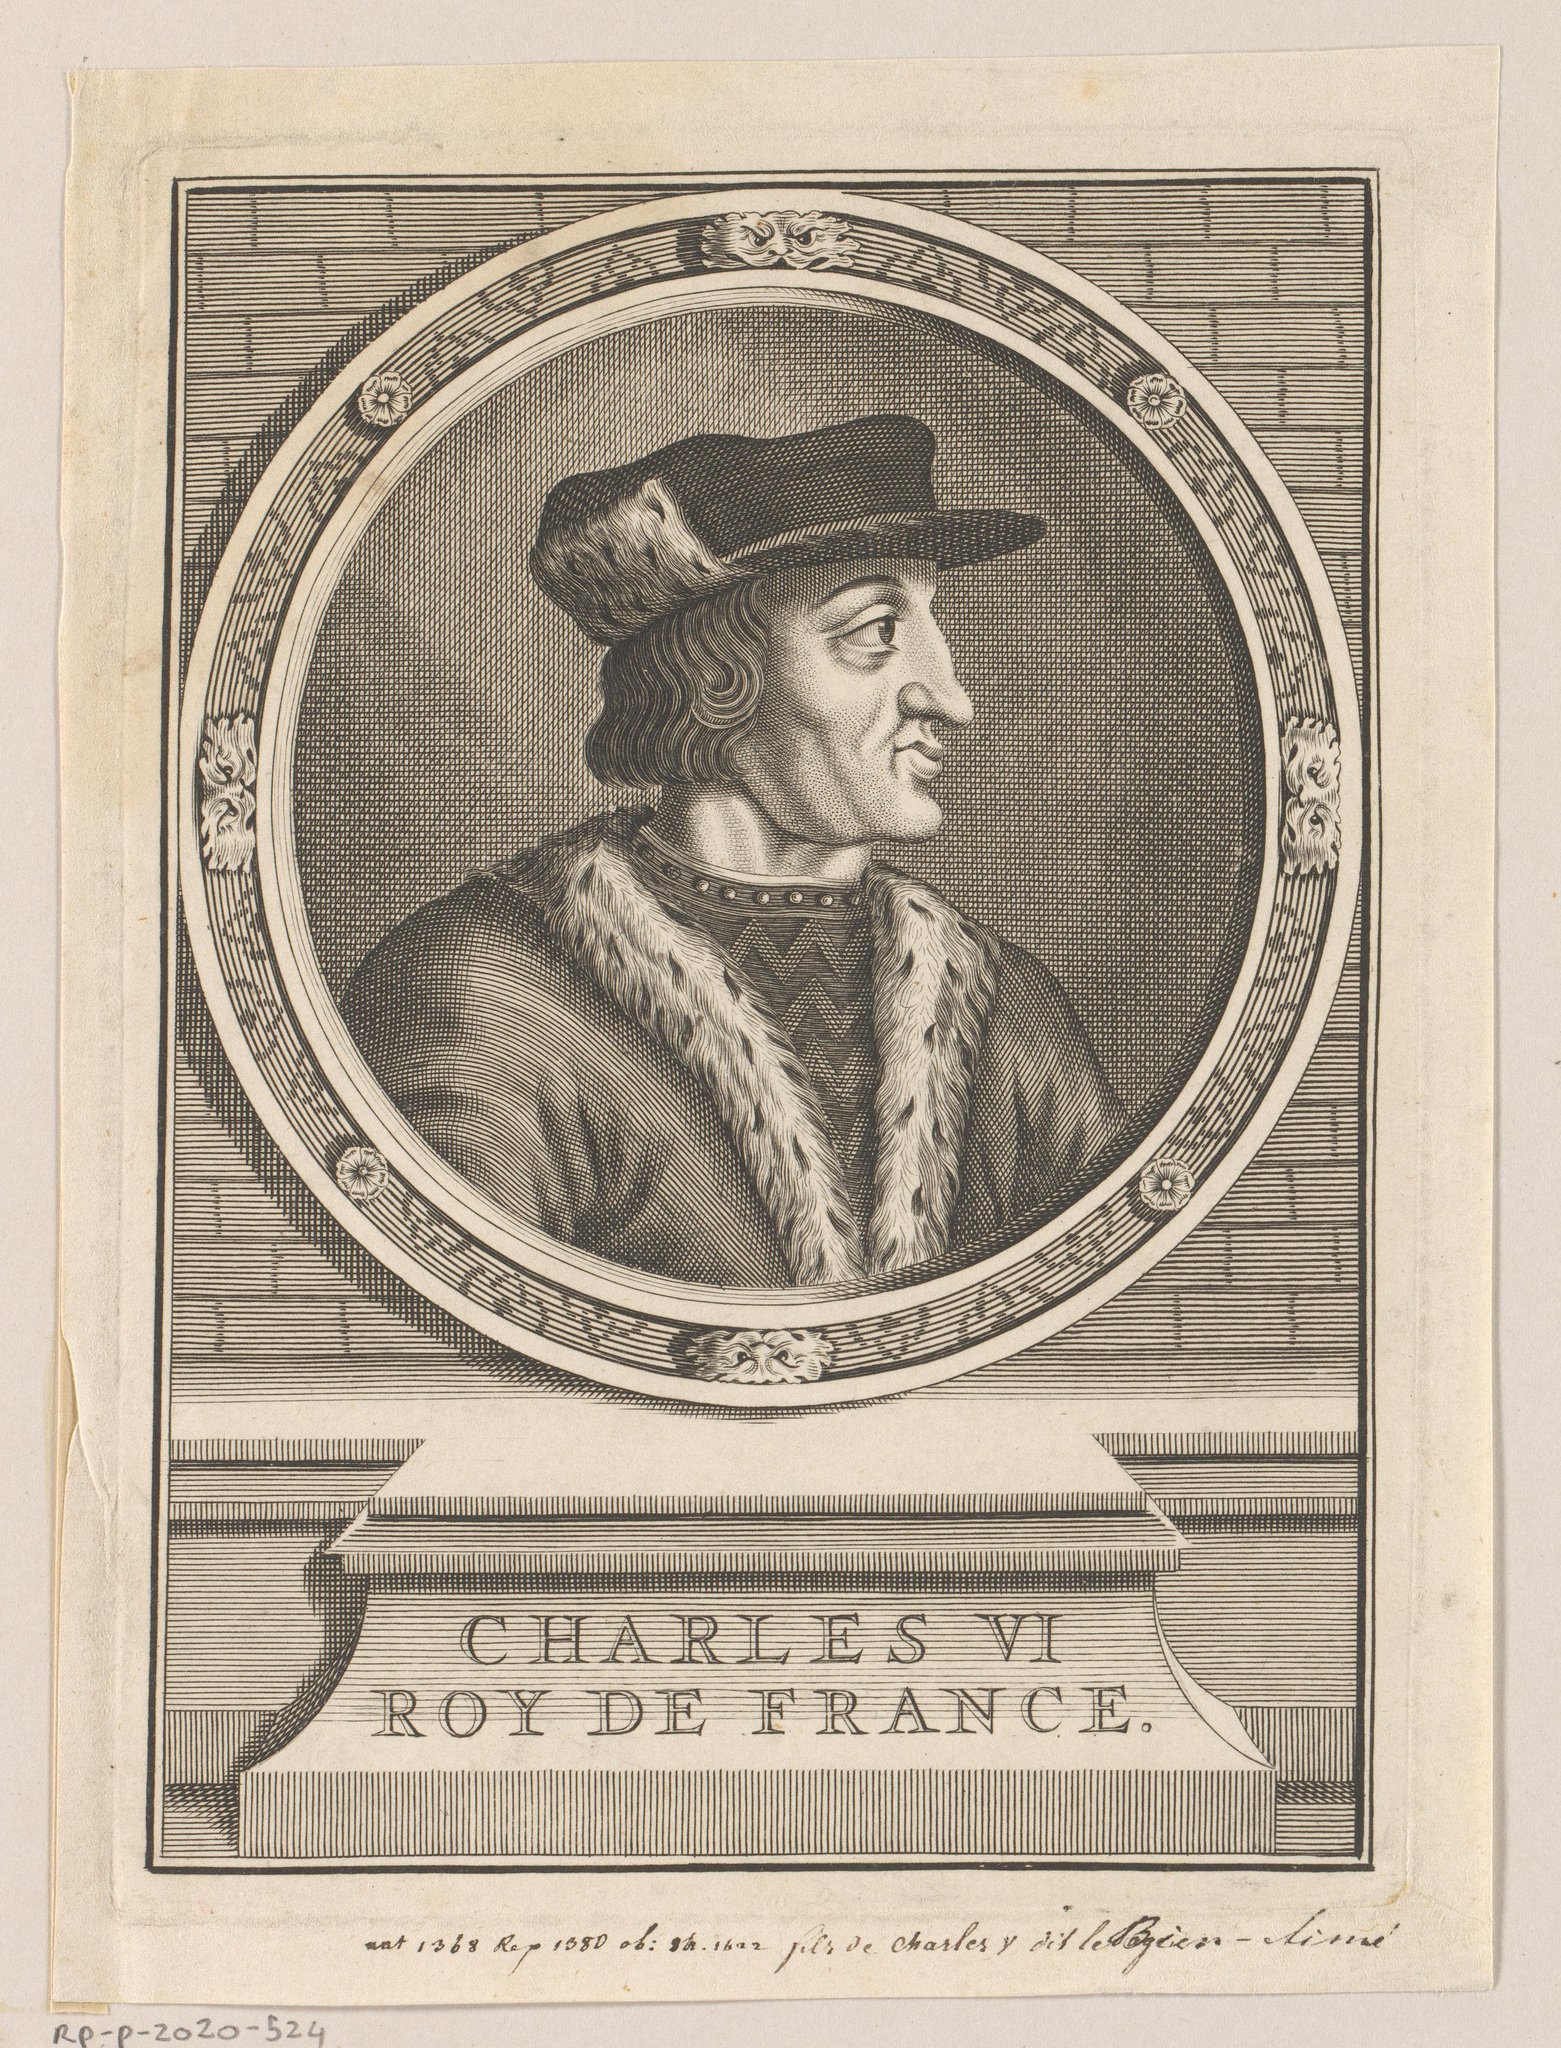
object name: book illustration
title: Portret van Karel VI, koning van Frankrijk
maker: Anonymous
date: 1724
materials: paper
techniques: engraving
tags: paris, historical persons, king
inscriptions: inscription: ‘nat 1368 Rep 1380 ob: [...]2 fils de Charles V (...)’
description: Prent gebruikt in: Lenfant, Jaques.Histoire du concile de Pise, et de ce qui dést passé de plus mémorable depuis ce consile jusqu'au consile de Constance. 2 dln. Amsterdam: Pierre Humbert, 1724, dl. 1.